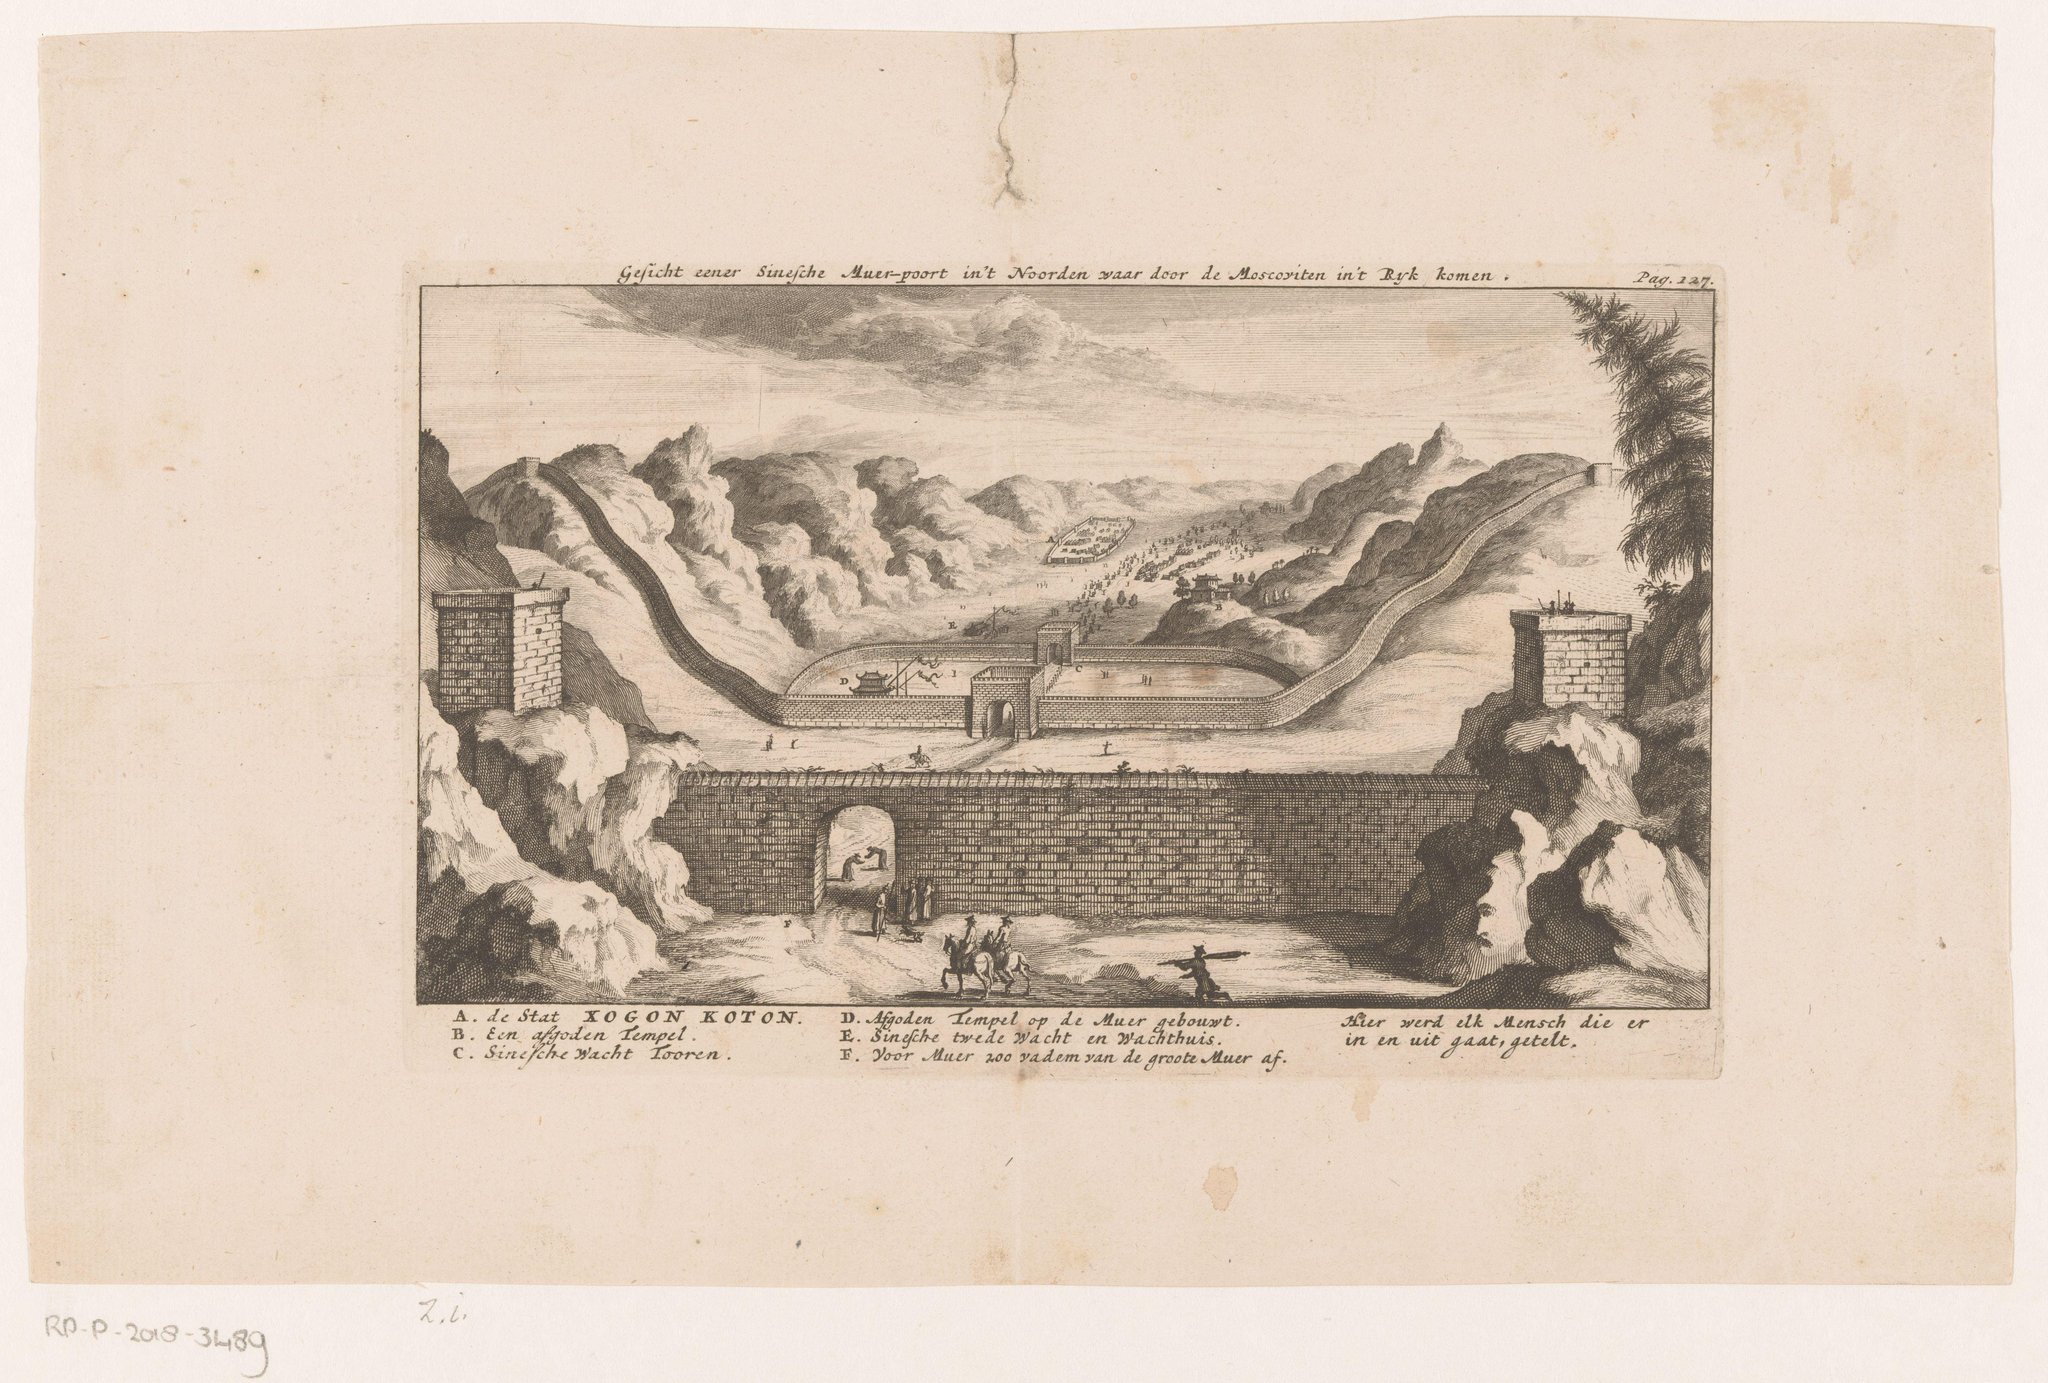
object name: book illustration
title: Gesicht eener Sinesche muer-poort in't Noorden waar door de Moscoviten in't Rijk komen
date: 1785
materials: paper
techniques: engraving, etching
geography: amsterdam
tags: landscape with other man-made constructions not mentioned above, e.g.: graveyards, playgrounds, etc.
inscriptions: collector's mark: Lugt 2228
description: Prent uit: Witsen, Nicolaas. Noord en oost Tartaryen: behelzende eene beschryving van verscheidene Tartersche en nabuurige gewesten (...). 2 dln. Amsterdam: M. Schalekamp, 1785 (2de editie), dl. 1, p. 127.